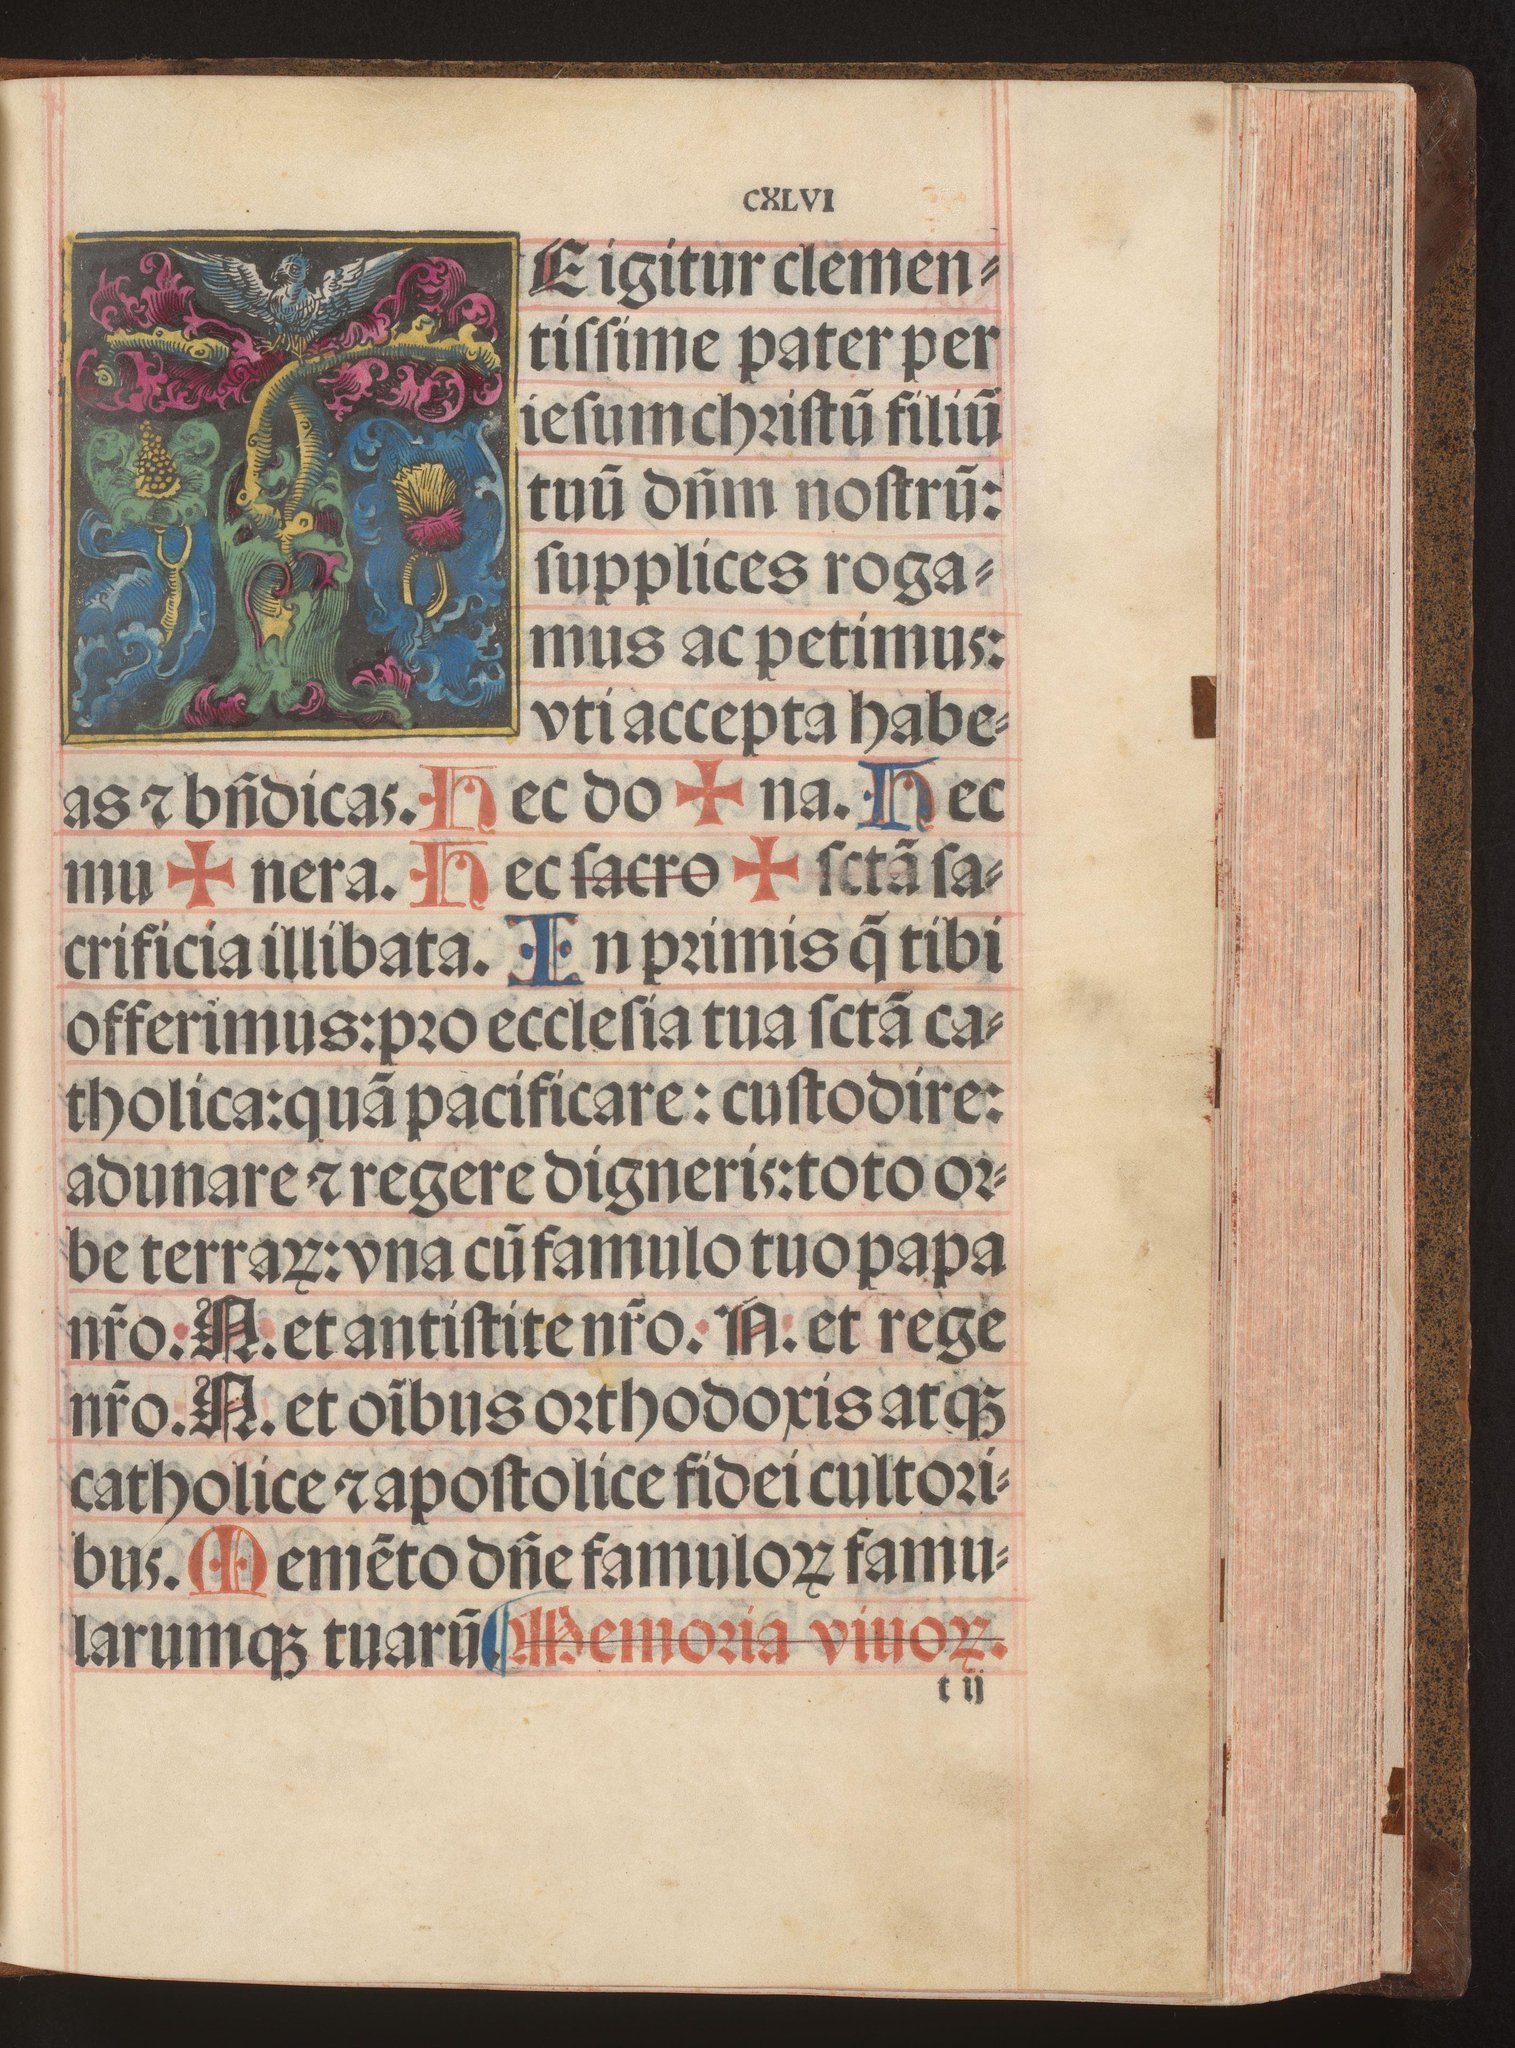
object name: print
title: Initiaal T (Zahltafel) met uil en randversiering van druiven en bladmotieven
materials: parchment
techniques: hand coloring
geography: vienna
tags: initial, owls